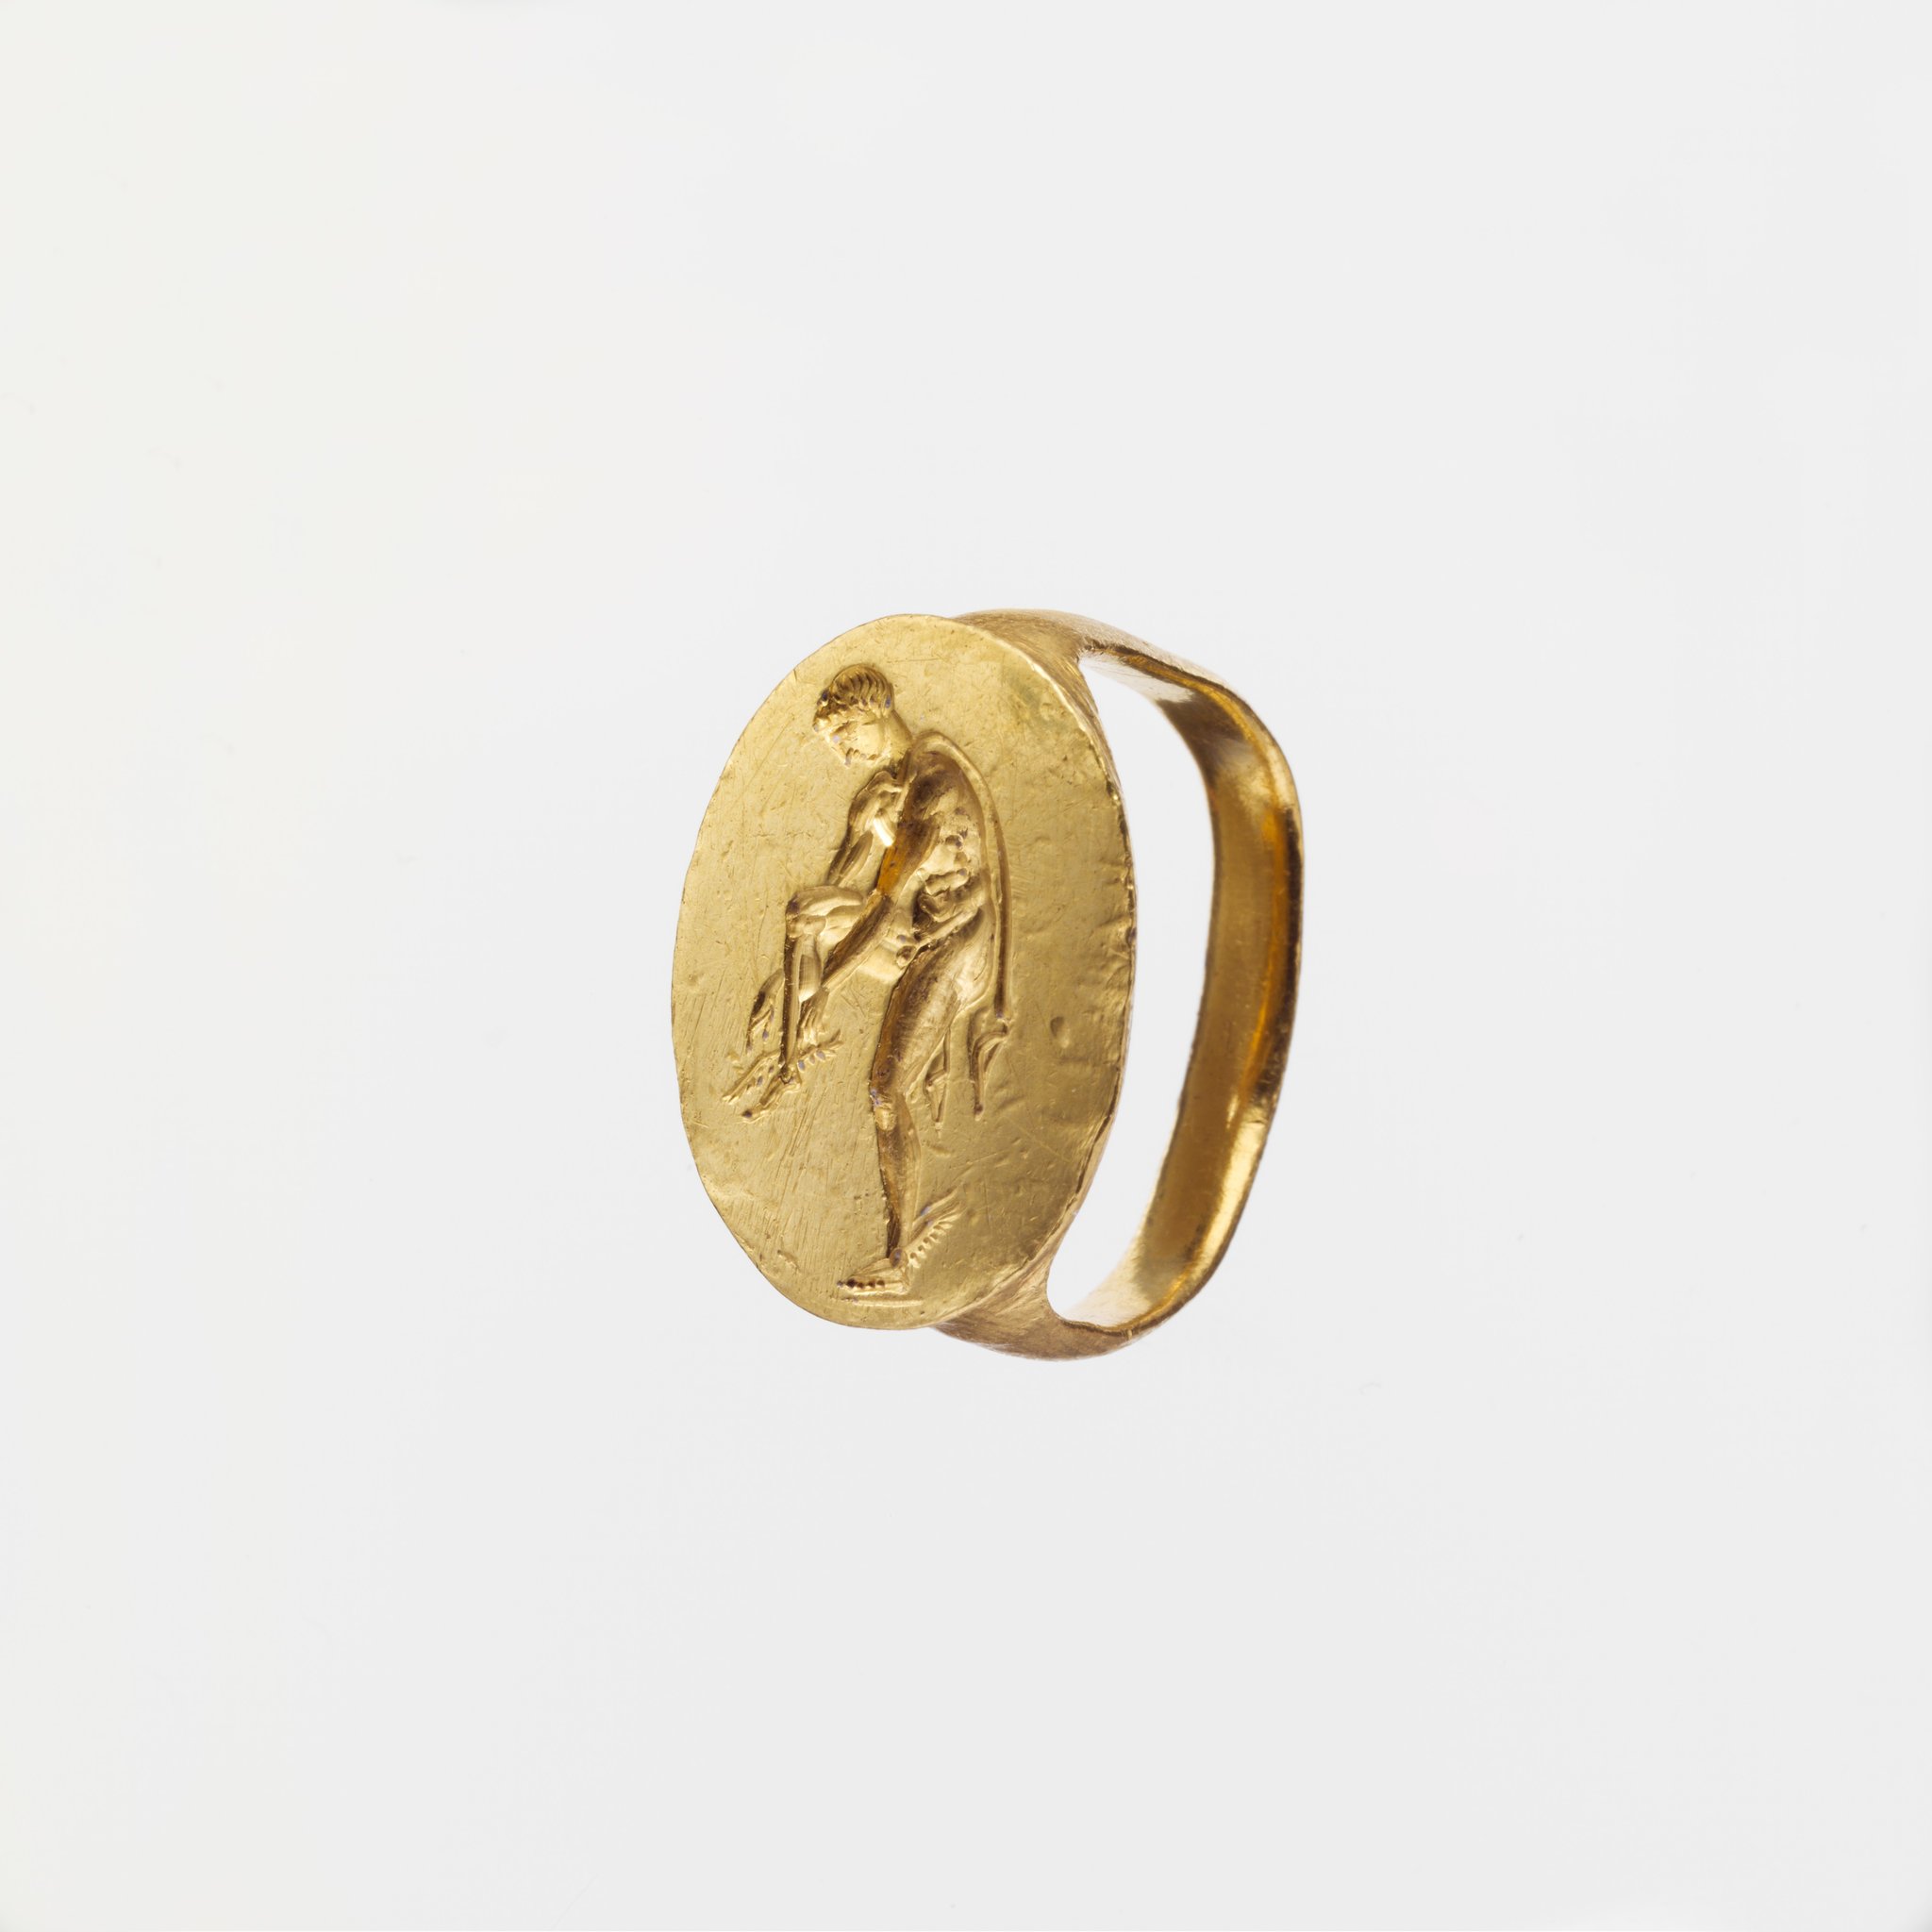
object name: ring with hermes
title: Gold finger ring engraved with an image of Hermes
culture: greek, south italian, tarentine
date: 334-301 BCE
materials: gold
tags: male nudes,hermes